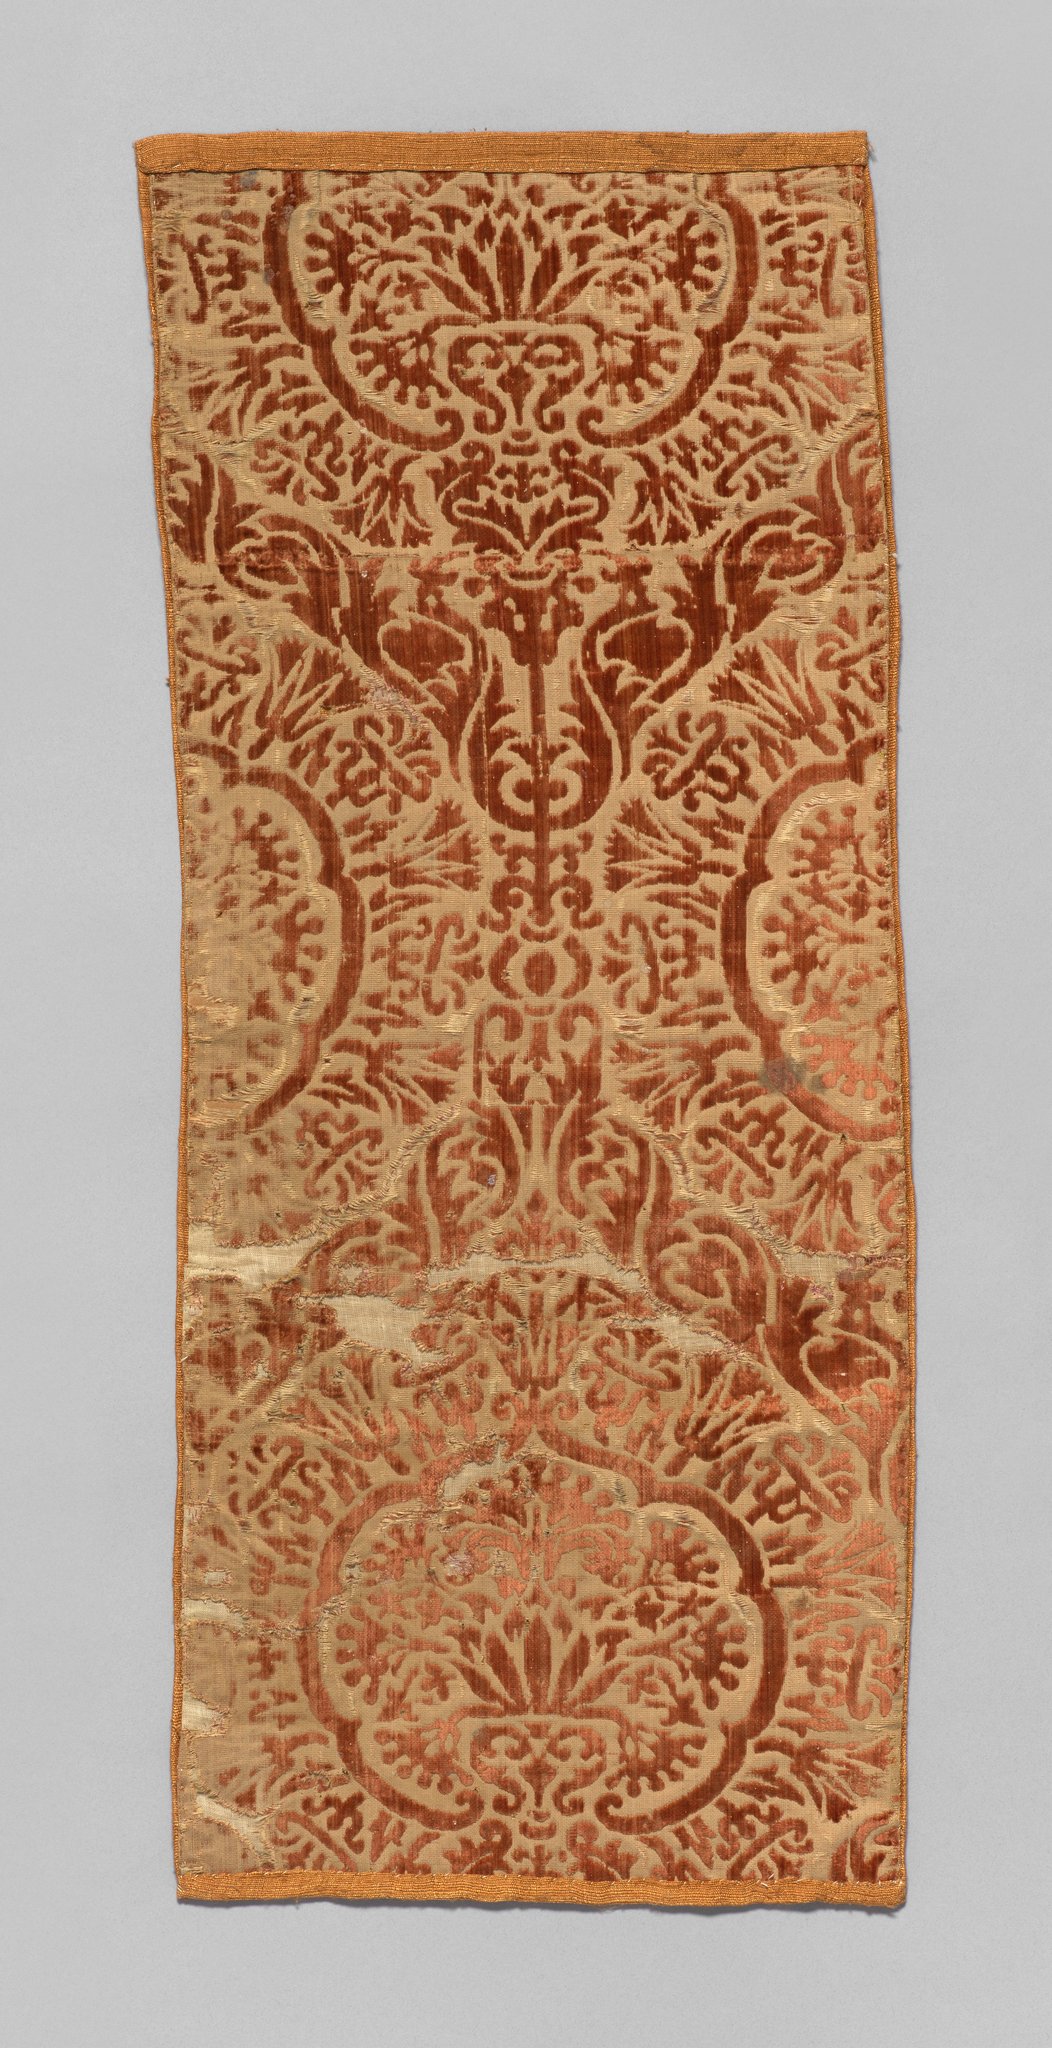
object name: piece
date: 1501-1600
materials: silk